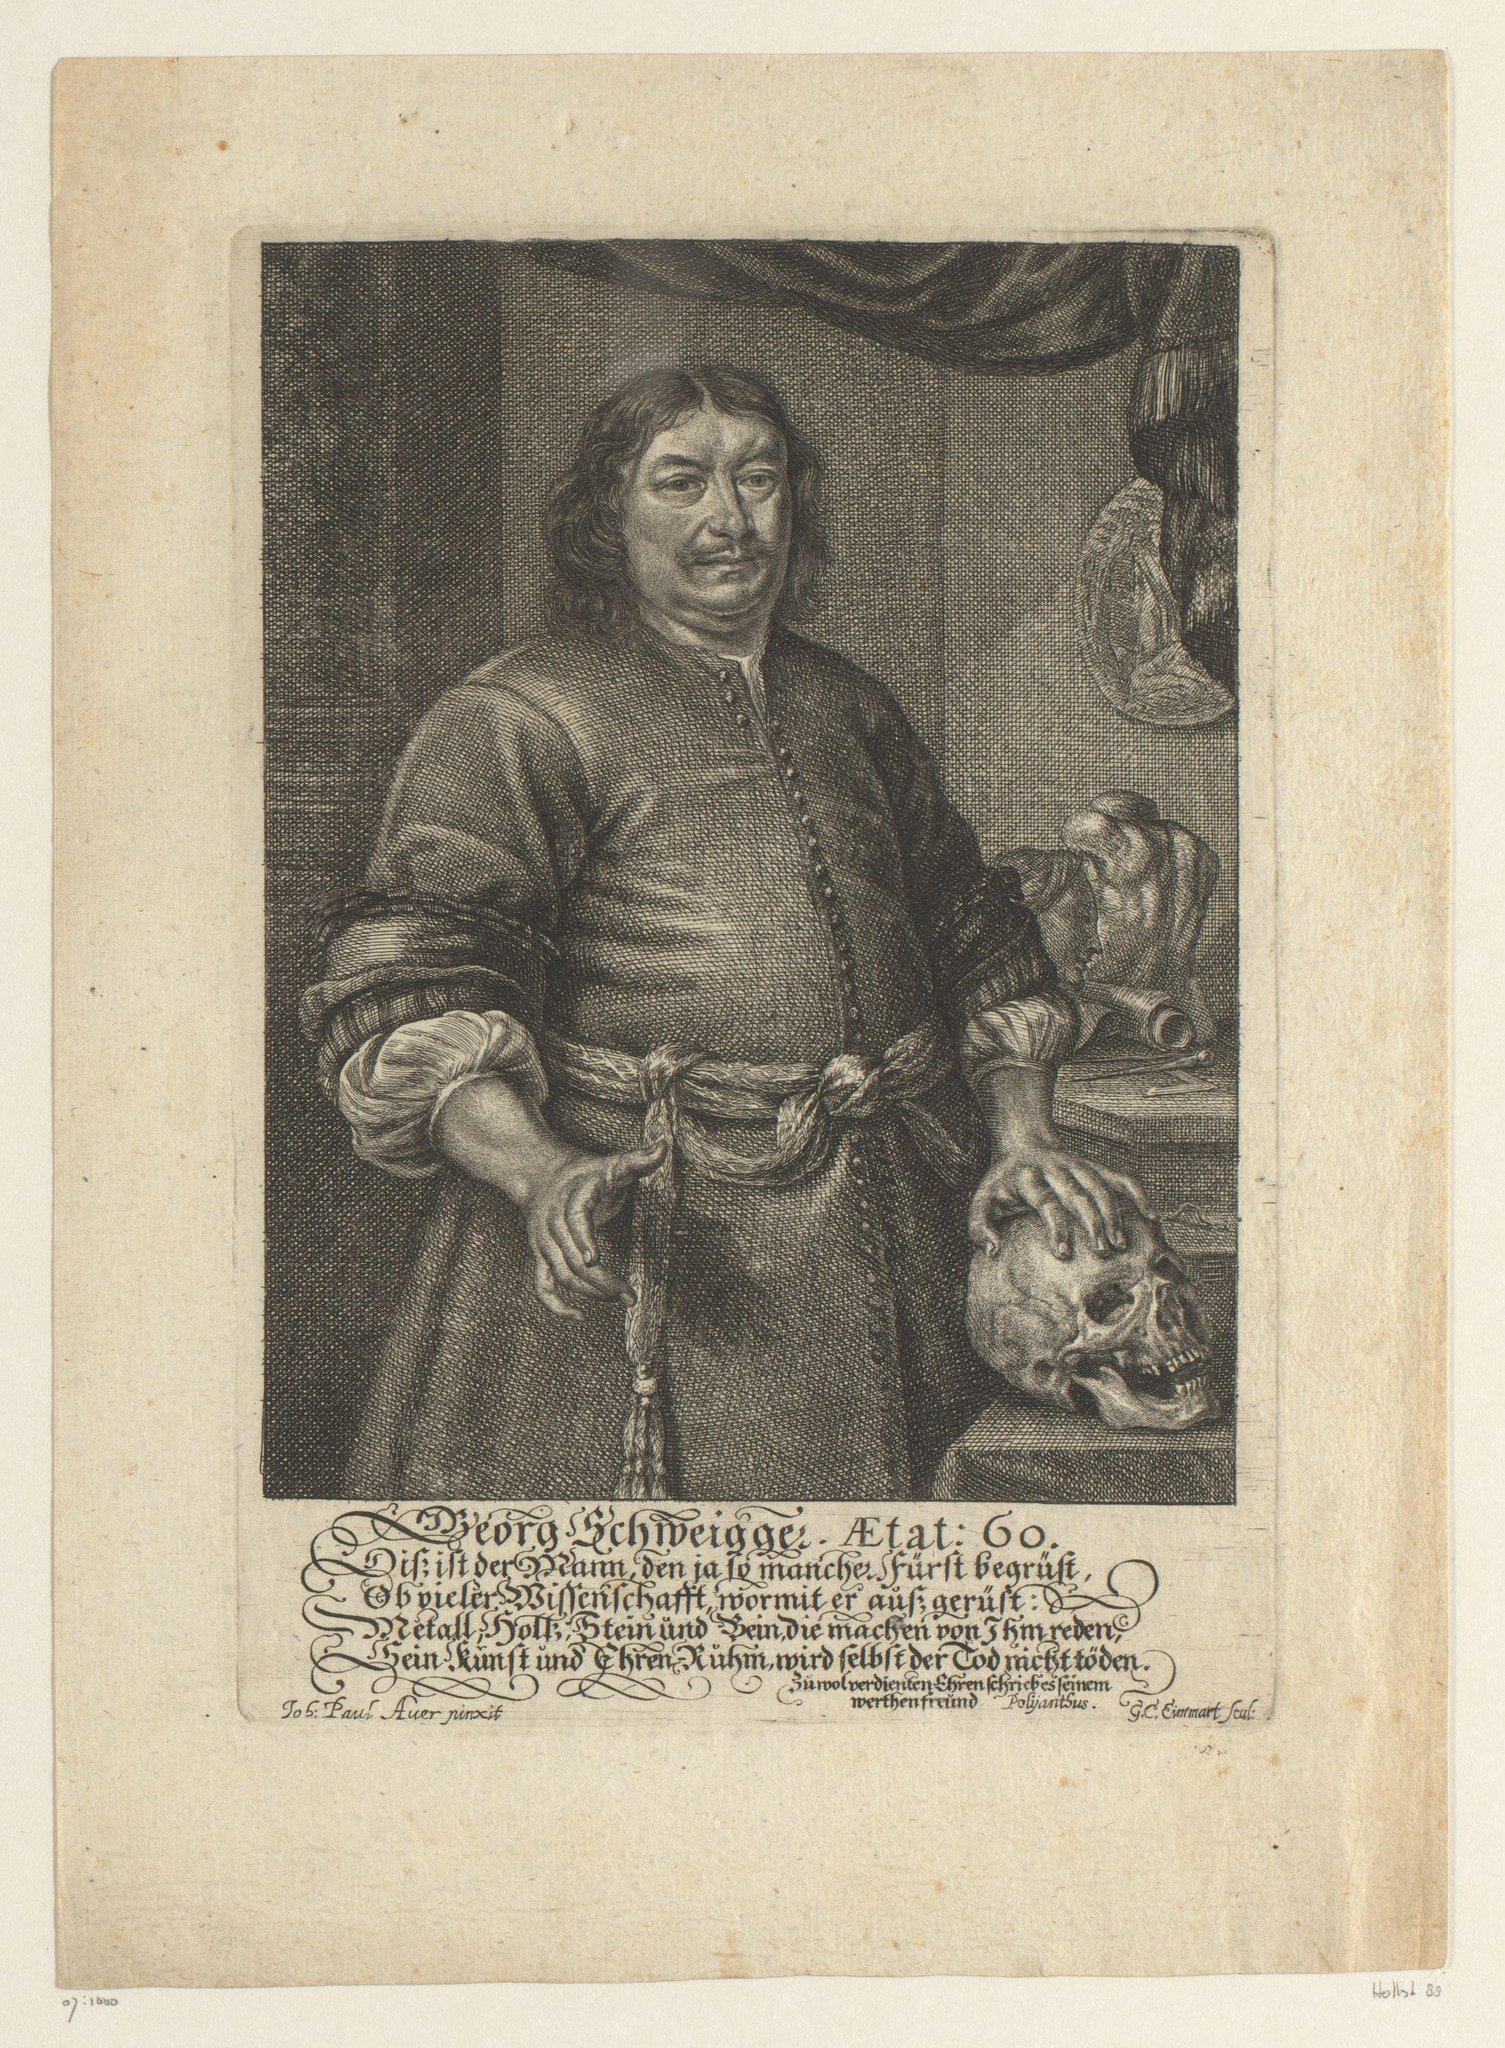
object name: print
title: Portret van Georg Schweigger op 60-jarige leeftijd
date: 1673-1705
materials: paper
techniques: engraving, etching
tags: sculptor, brazier, georg schweigger, portrait, self-portrait of sculptor, historical persons, skull as symbol of 'vanitas', tools, implements of sculptor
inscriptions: collector's mark: Lugt 2228